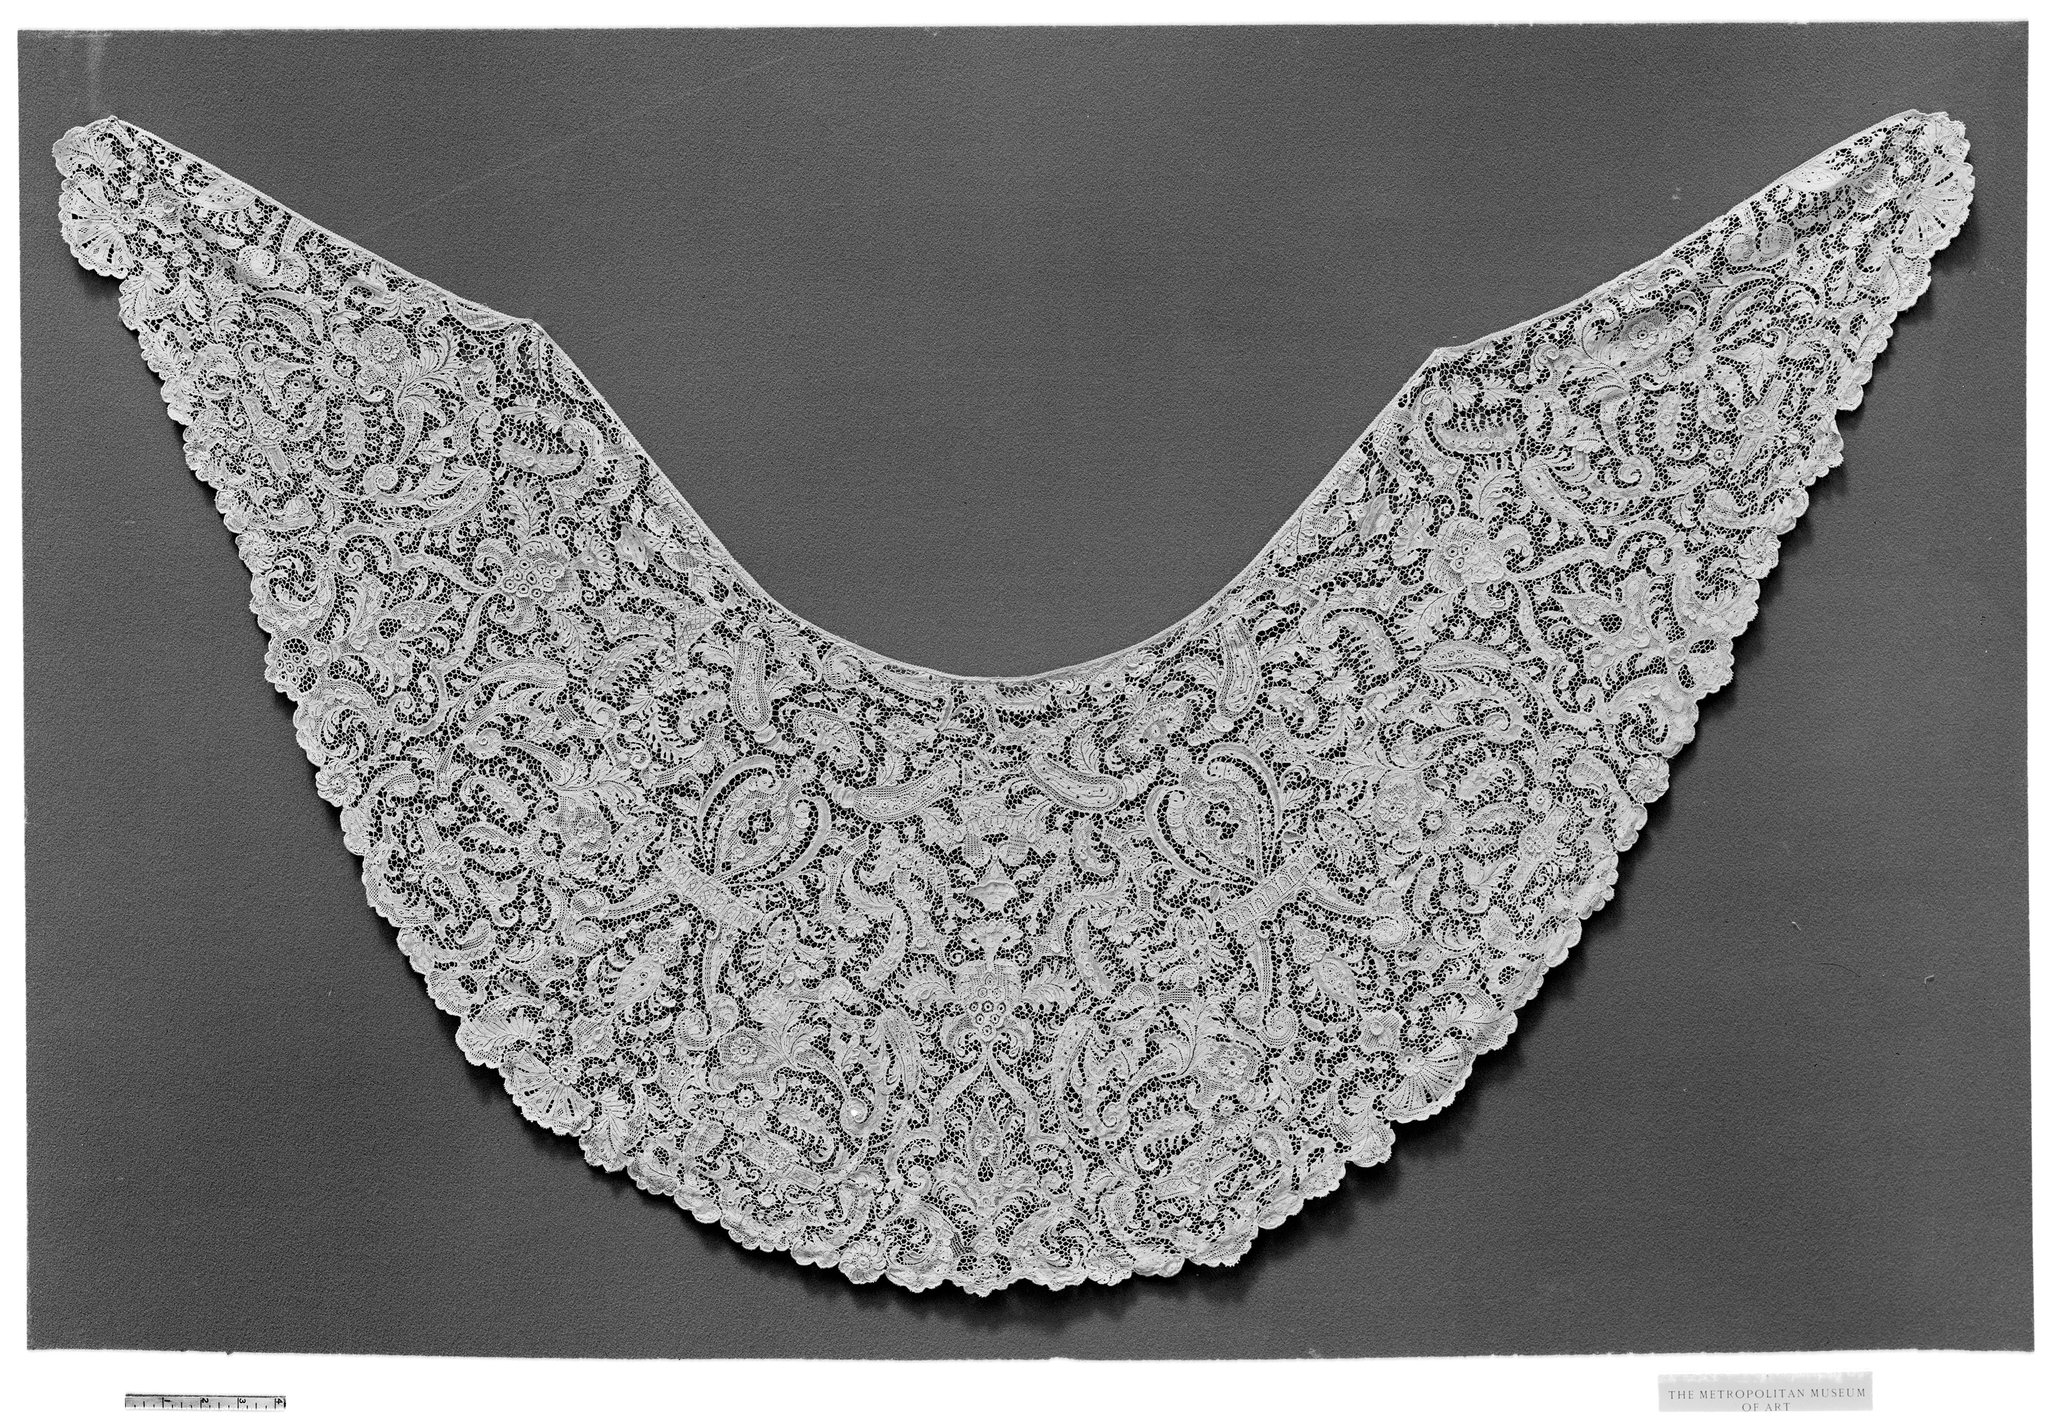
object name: cape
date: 1734-1766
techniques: lace